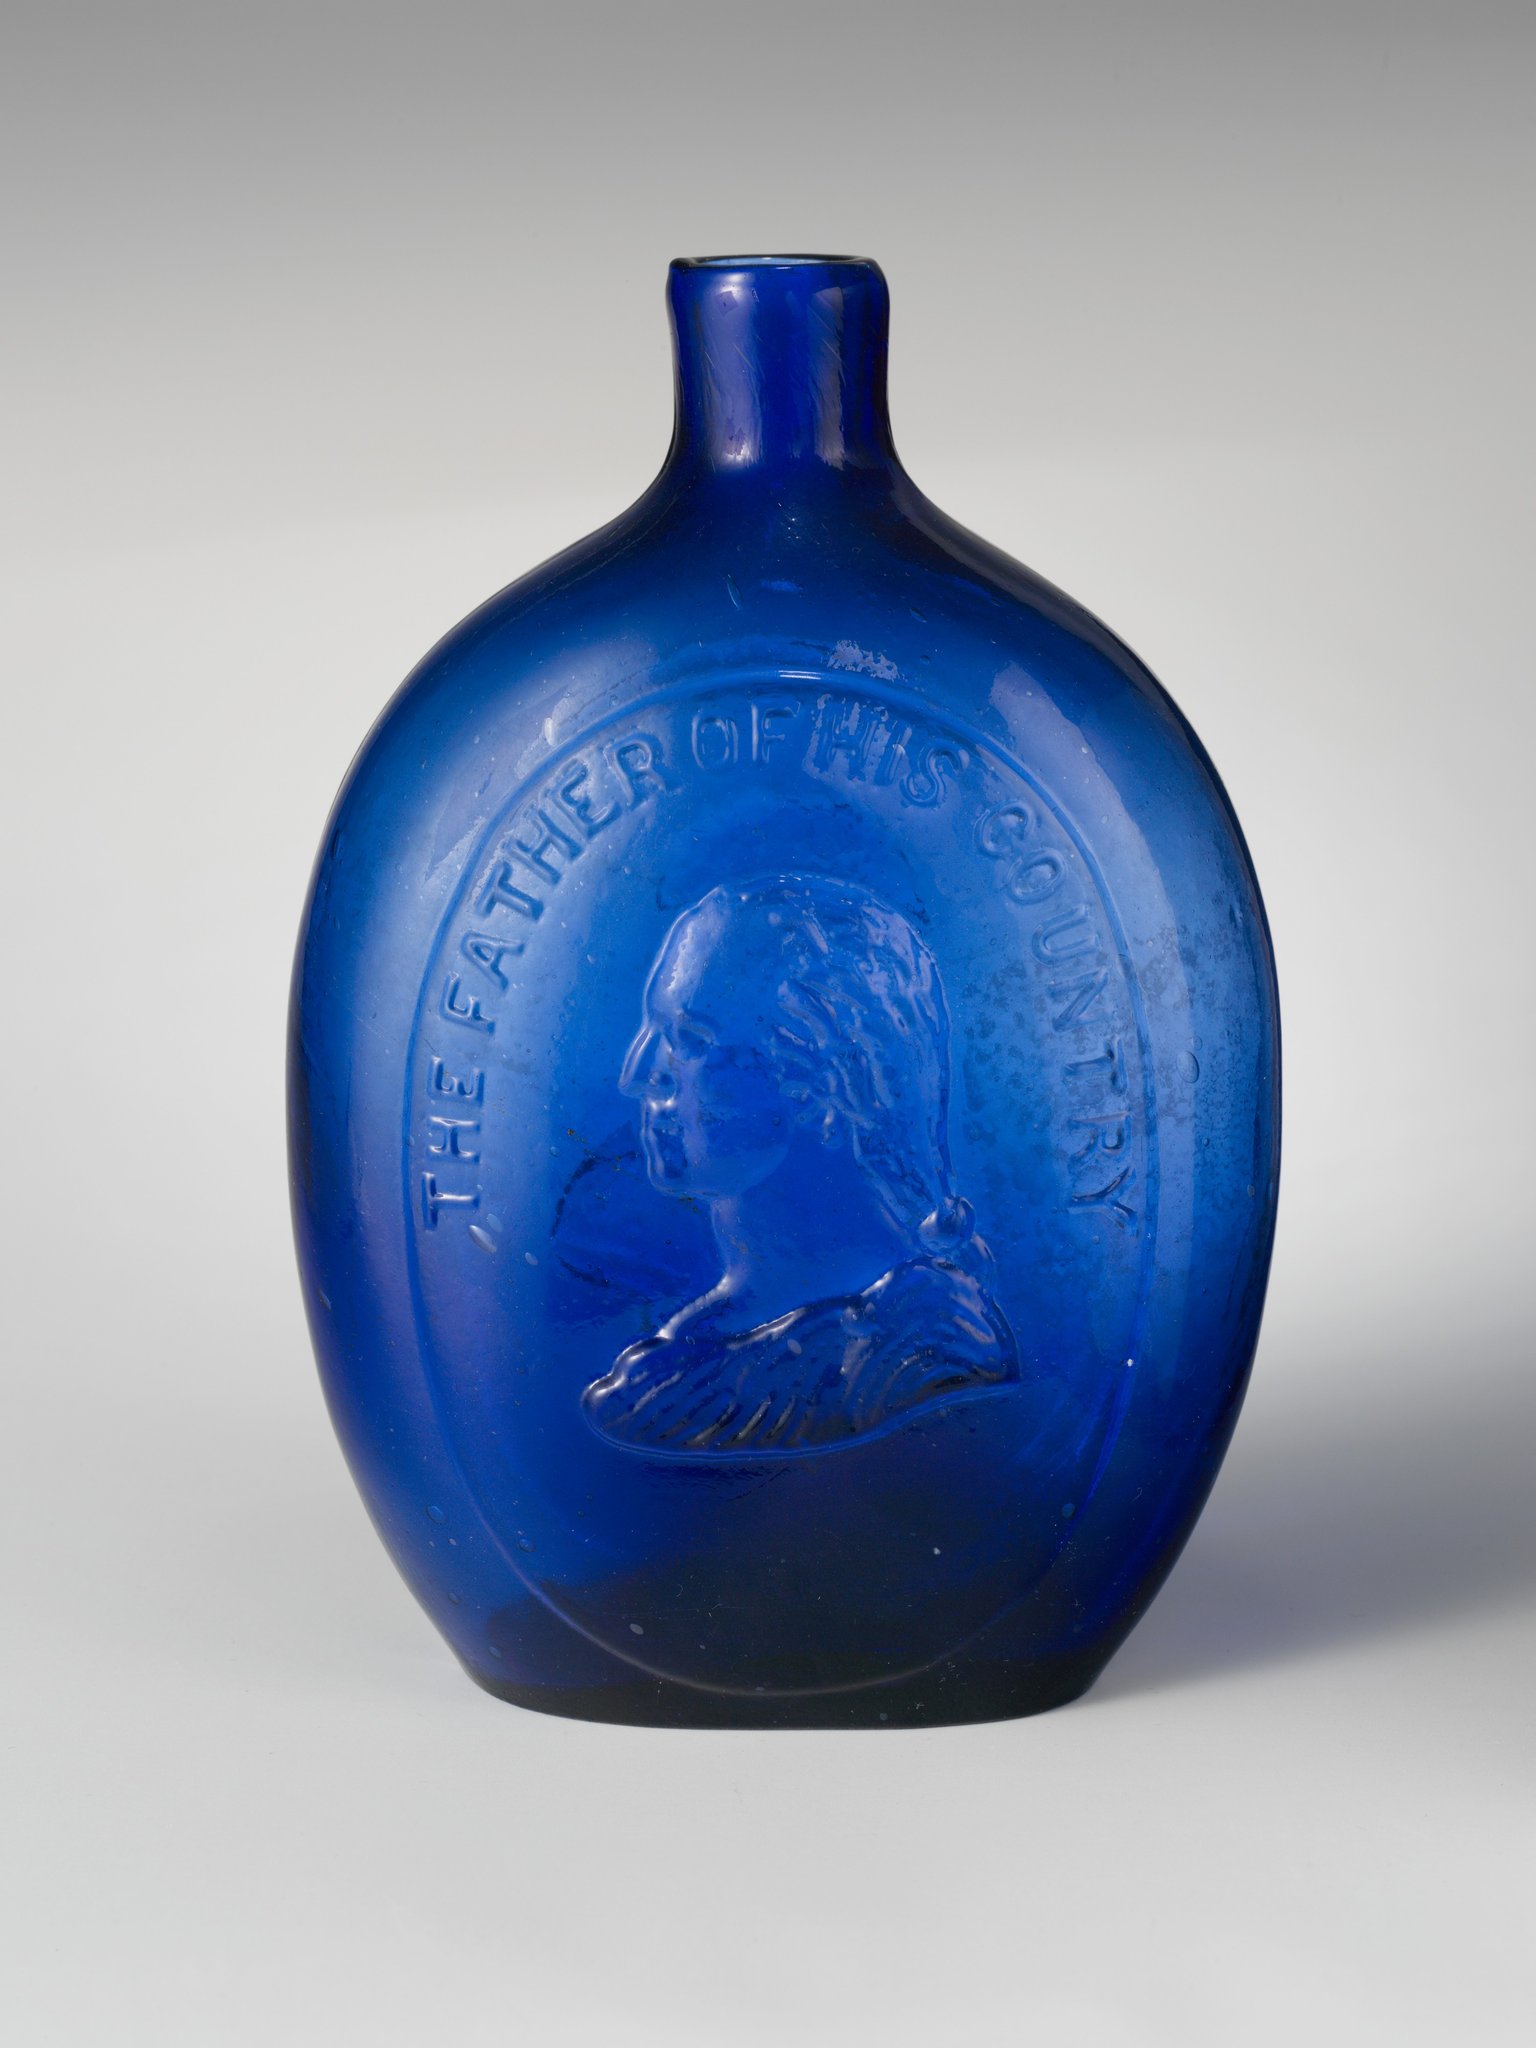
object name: flask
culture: american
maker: dyottville glass works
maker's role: maker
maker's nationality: american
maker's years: 1833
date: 1847-1848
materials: glass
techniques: glassblowing, molding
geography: united states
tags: george washington,men,profiles